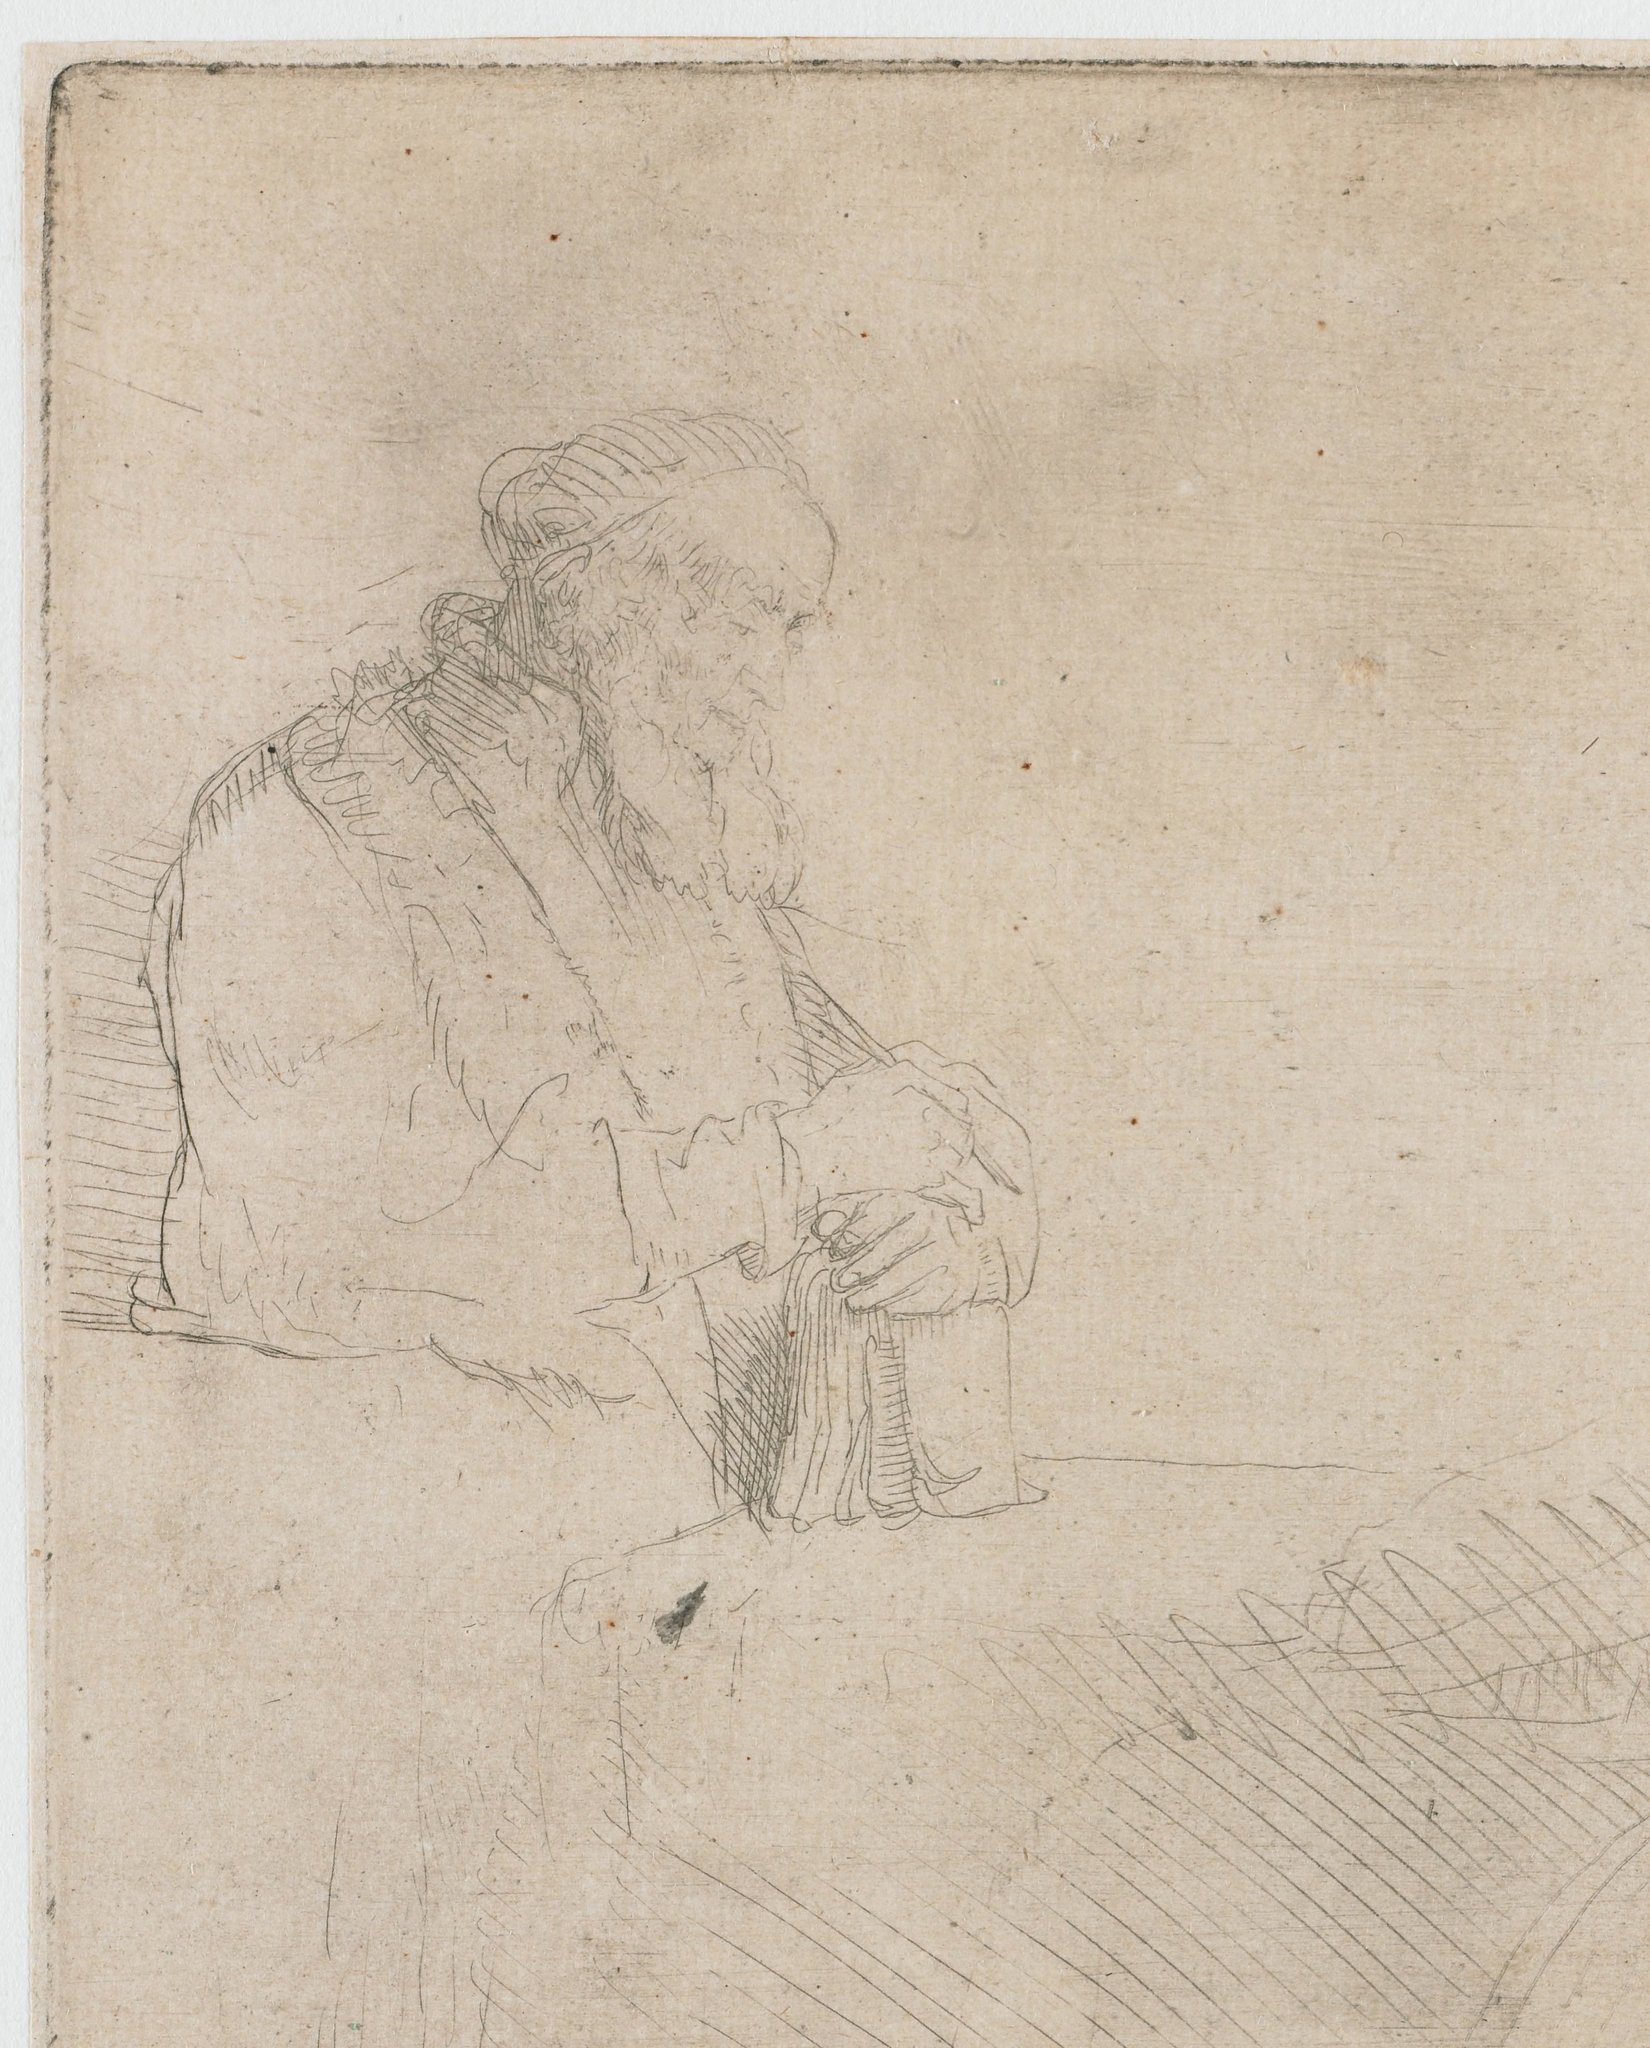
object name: print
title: Old man in meditation, leaning on a book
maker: rembrandt van rijn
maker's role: draughtsman, painter, print maker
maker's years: 1606-1669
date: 1645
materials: paper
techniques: drypoint, etching, intaglio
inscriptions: collector's mark: Lugt 2165, collector's mark: Lugt 2165, collector's mark: Lugt 573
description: Because of the way in which Rembrandt depicted his models, his tronies of men often have a tranquil disposition. They are idle. Here he placed one of the old men in a more narrative context. Standing behind a table, the man leans on a book, lost in thought. Before him can just be seen a part of a globe. Perhaps he is a scholar or a philosopher.